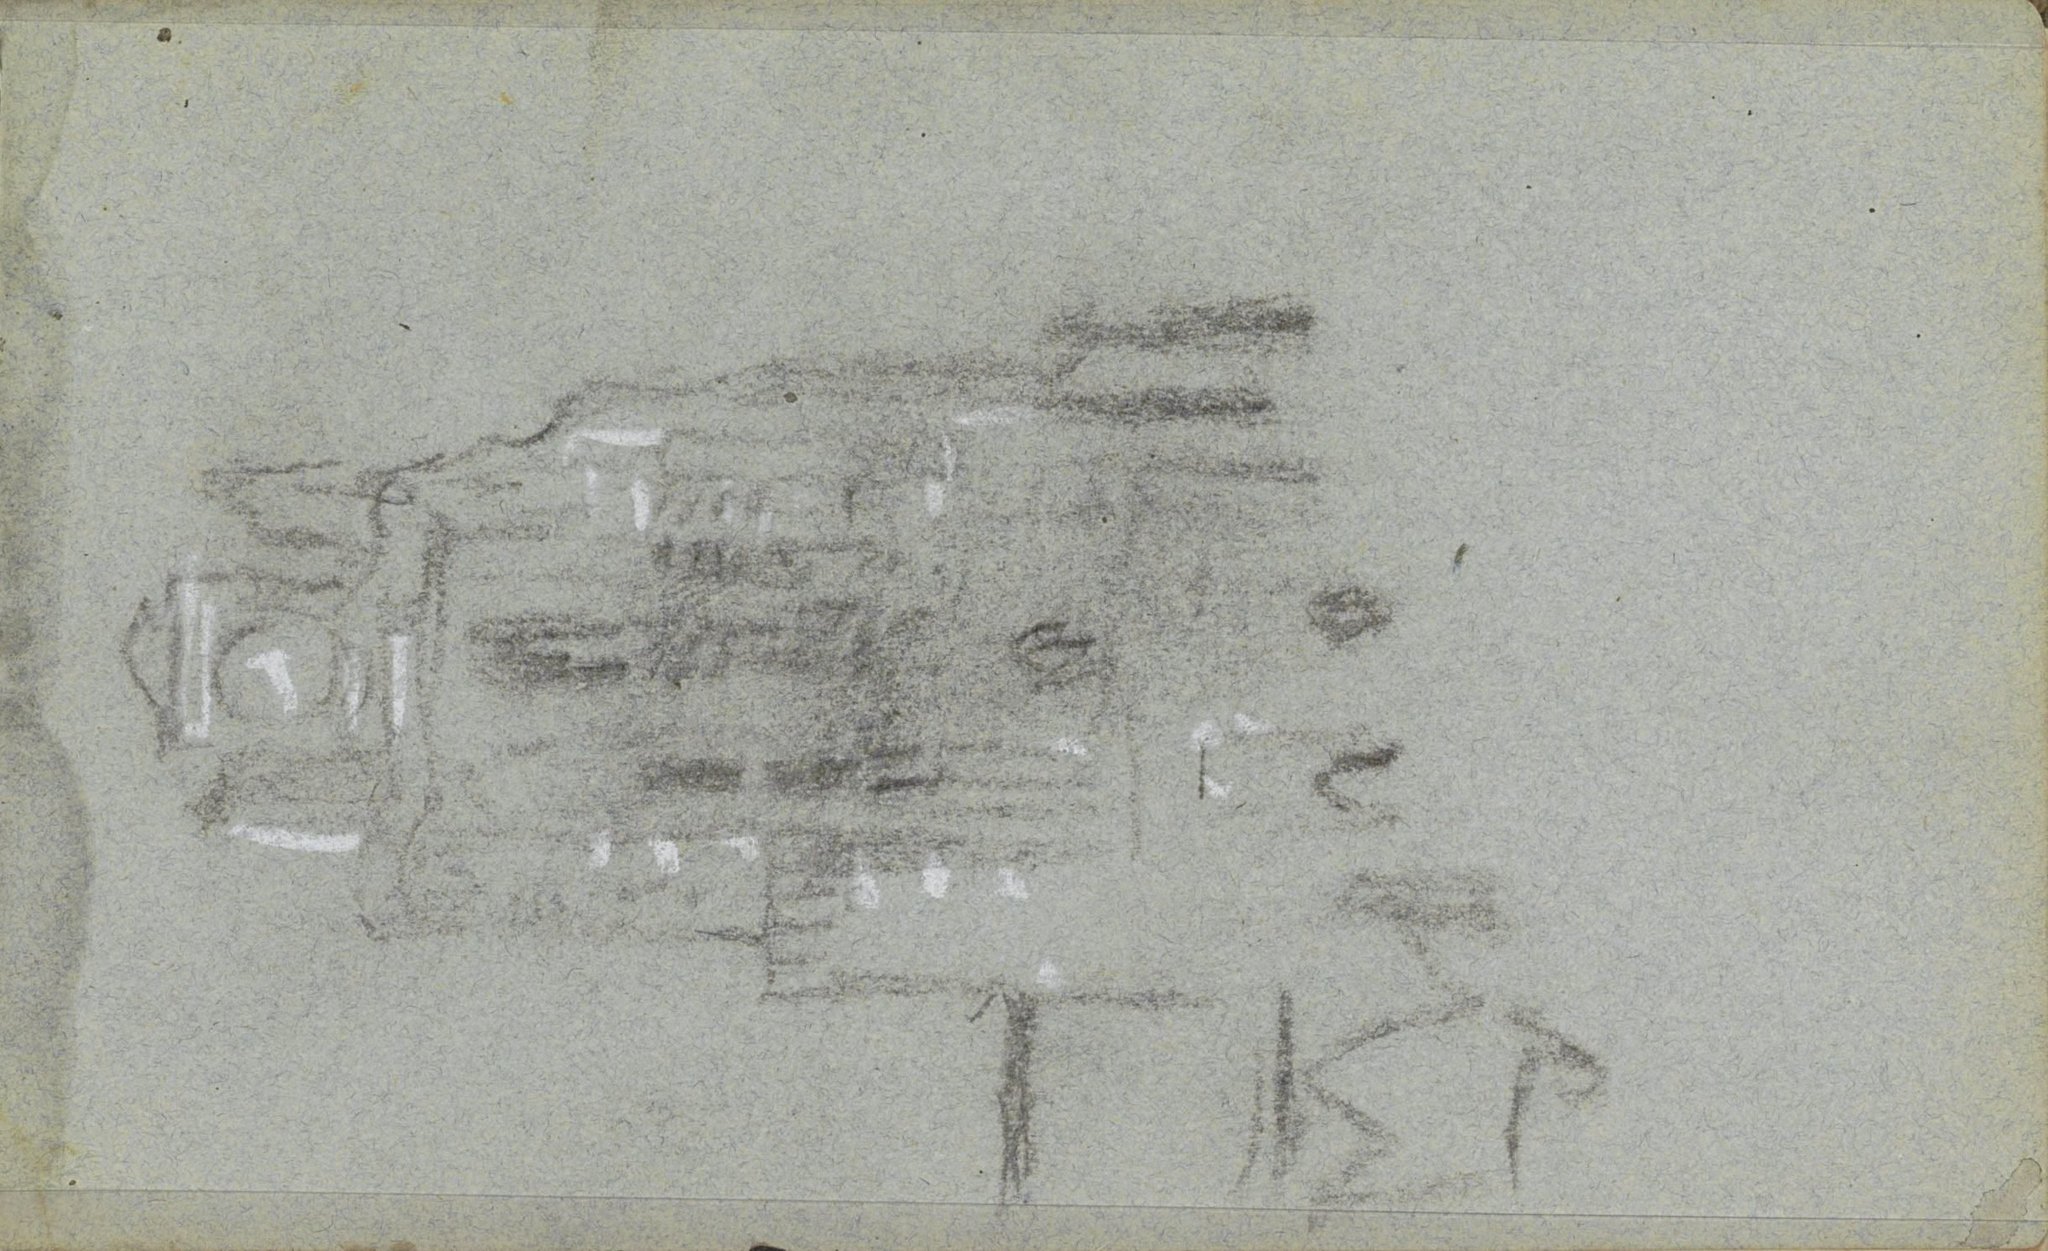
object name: sketchbook leaf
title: Toren met een uurwerk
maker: jozef israëls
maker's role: draughtsman, painter, print maker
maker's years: 1824-1911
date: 1834-1911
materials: chalk, paper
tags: tower, clock tower ~ monumental adornment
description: Blad 24 recto uit een schetsboek met 42 bladen.